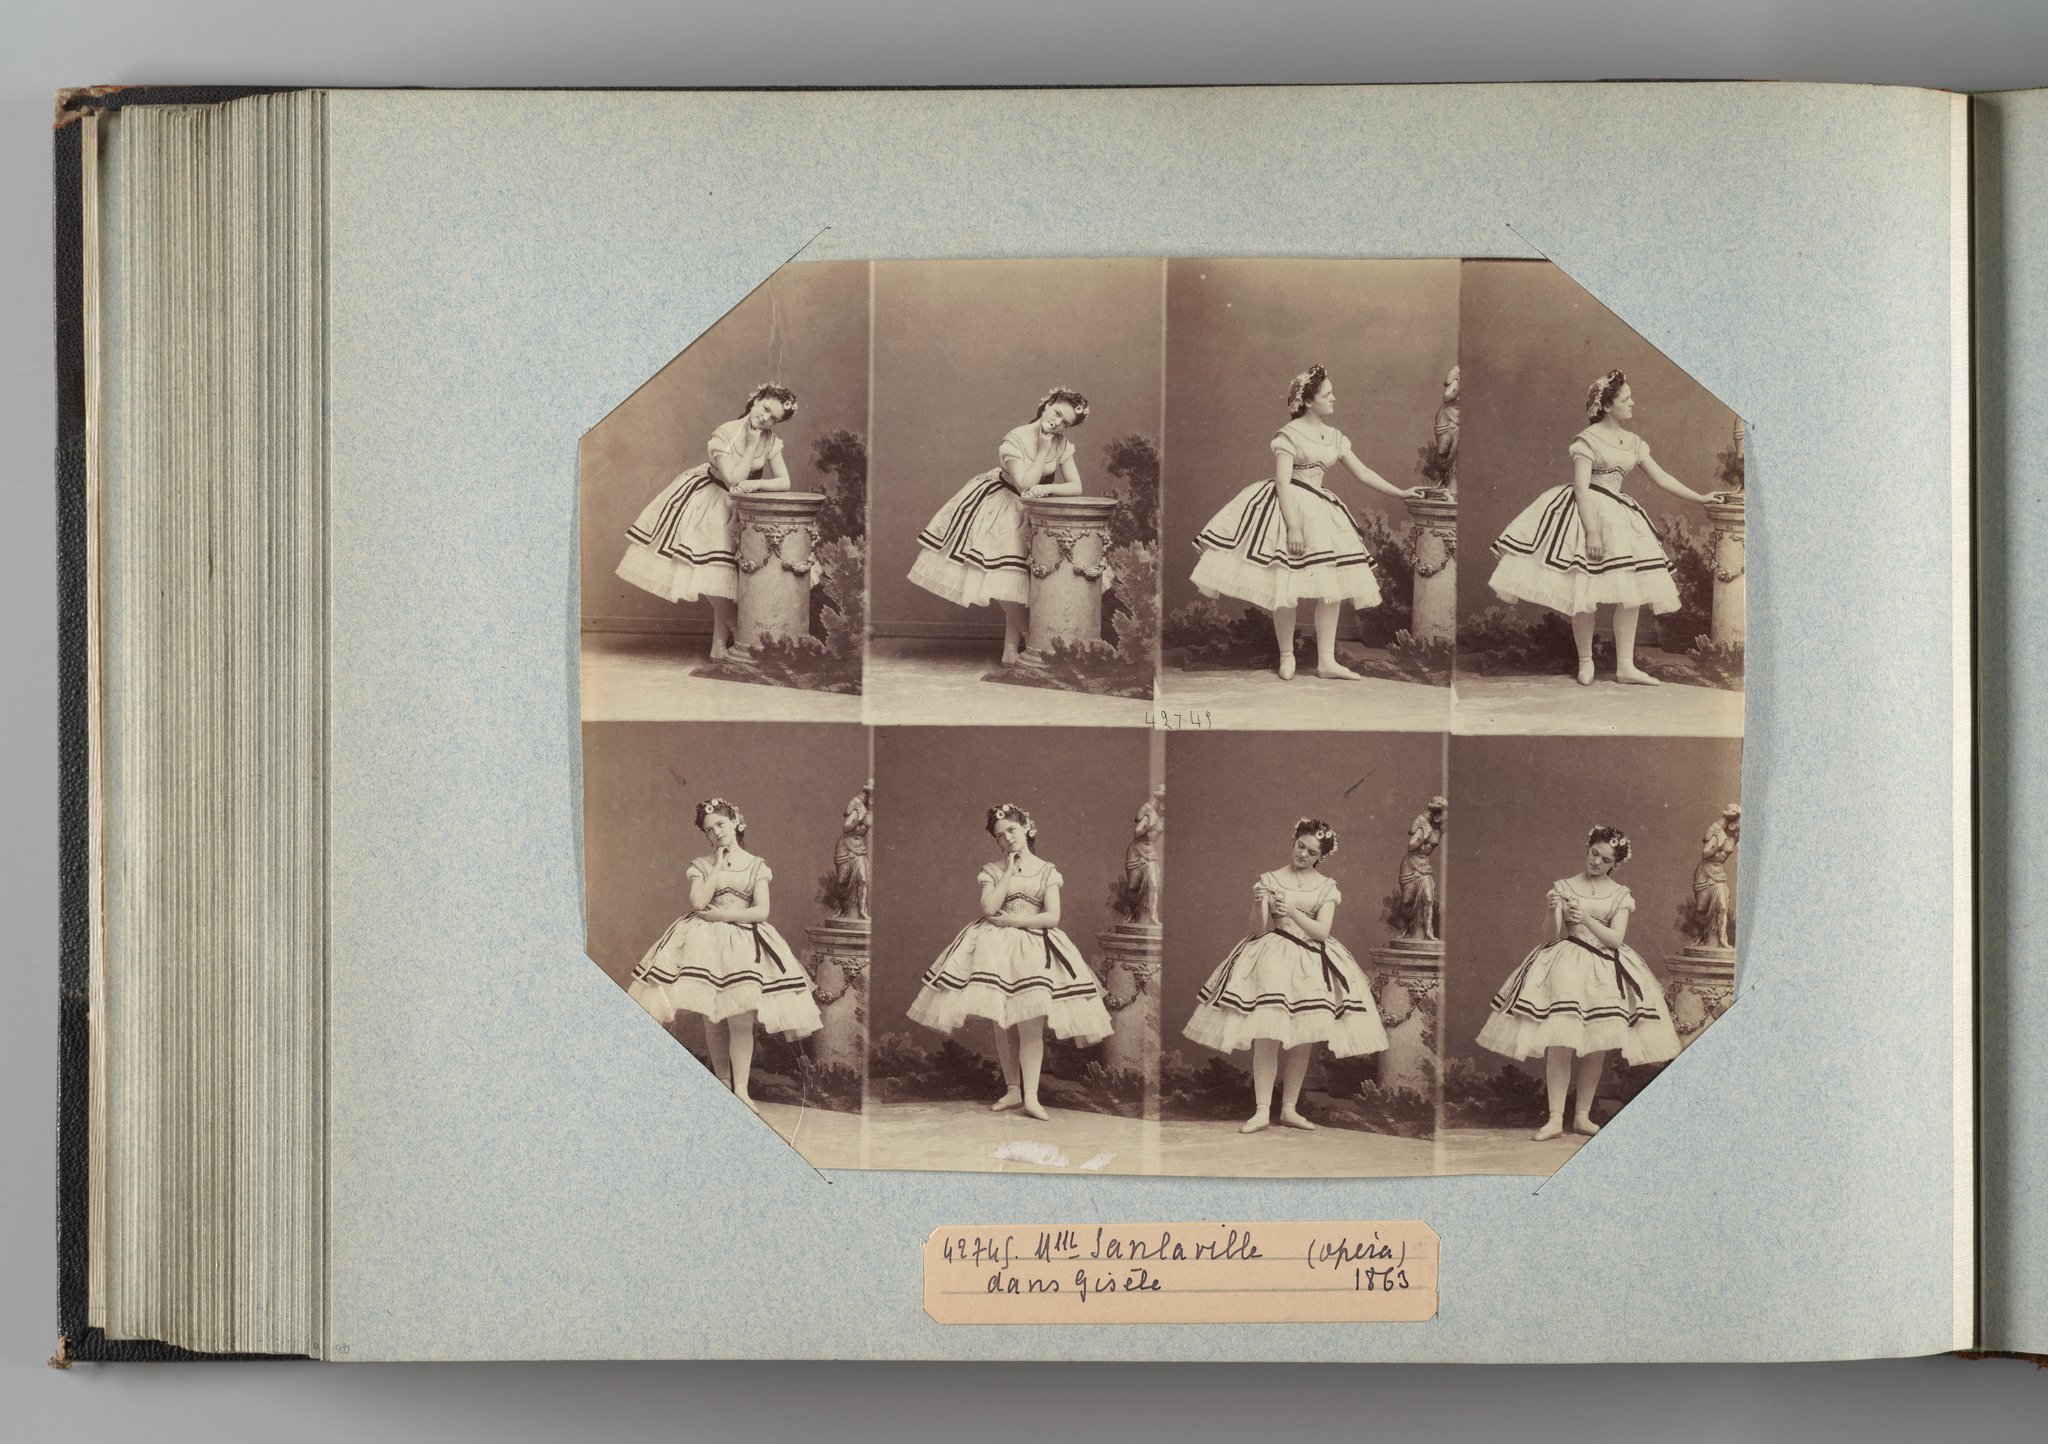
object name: photograph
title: Mlle Sanlaville dans Gisèle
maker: andré-adolphe-eugène disdéri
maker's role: artist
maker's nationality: french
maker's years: 1819-1889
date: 1863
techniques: albumen silver print, glass negative